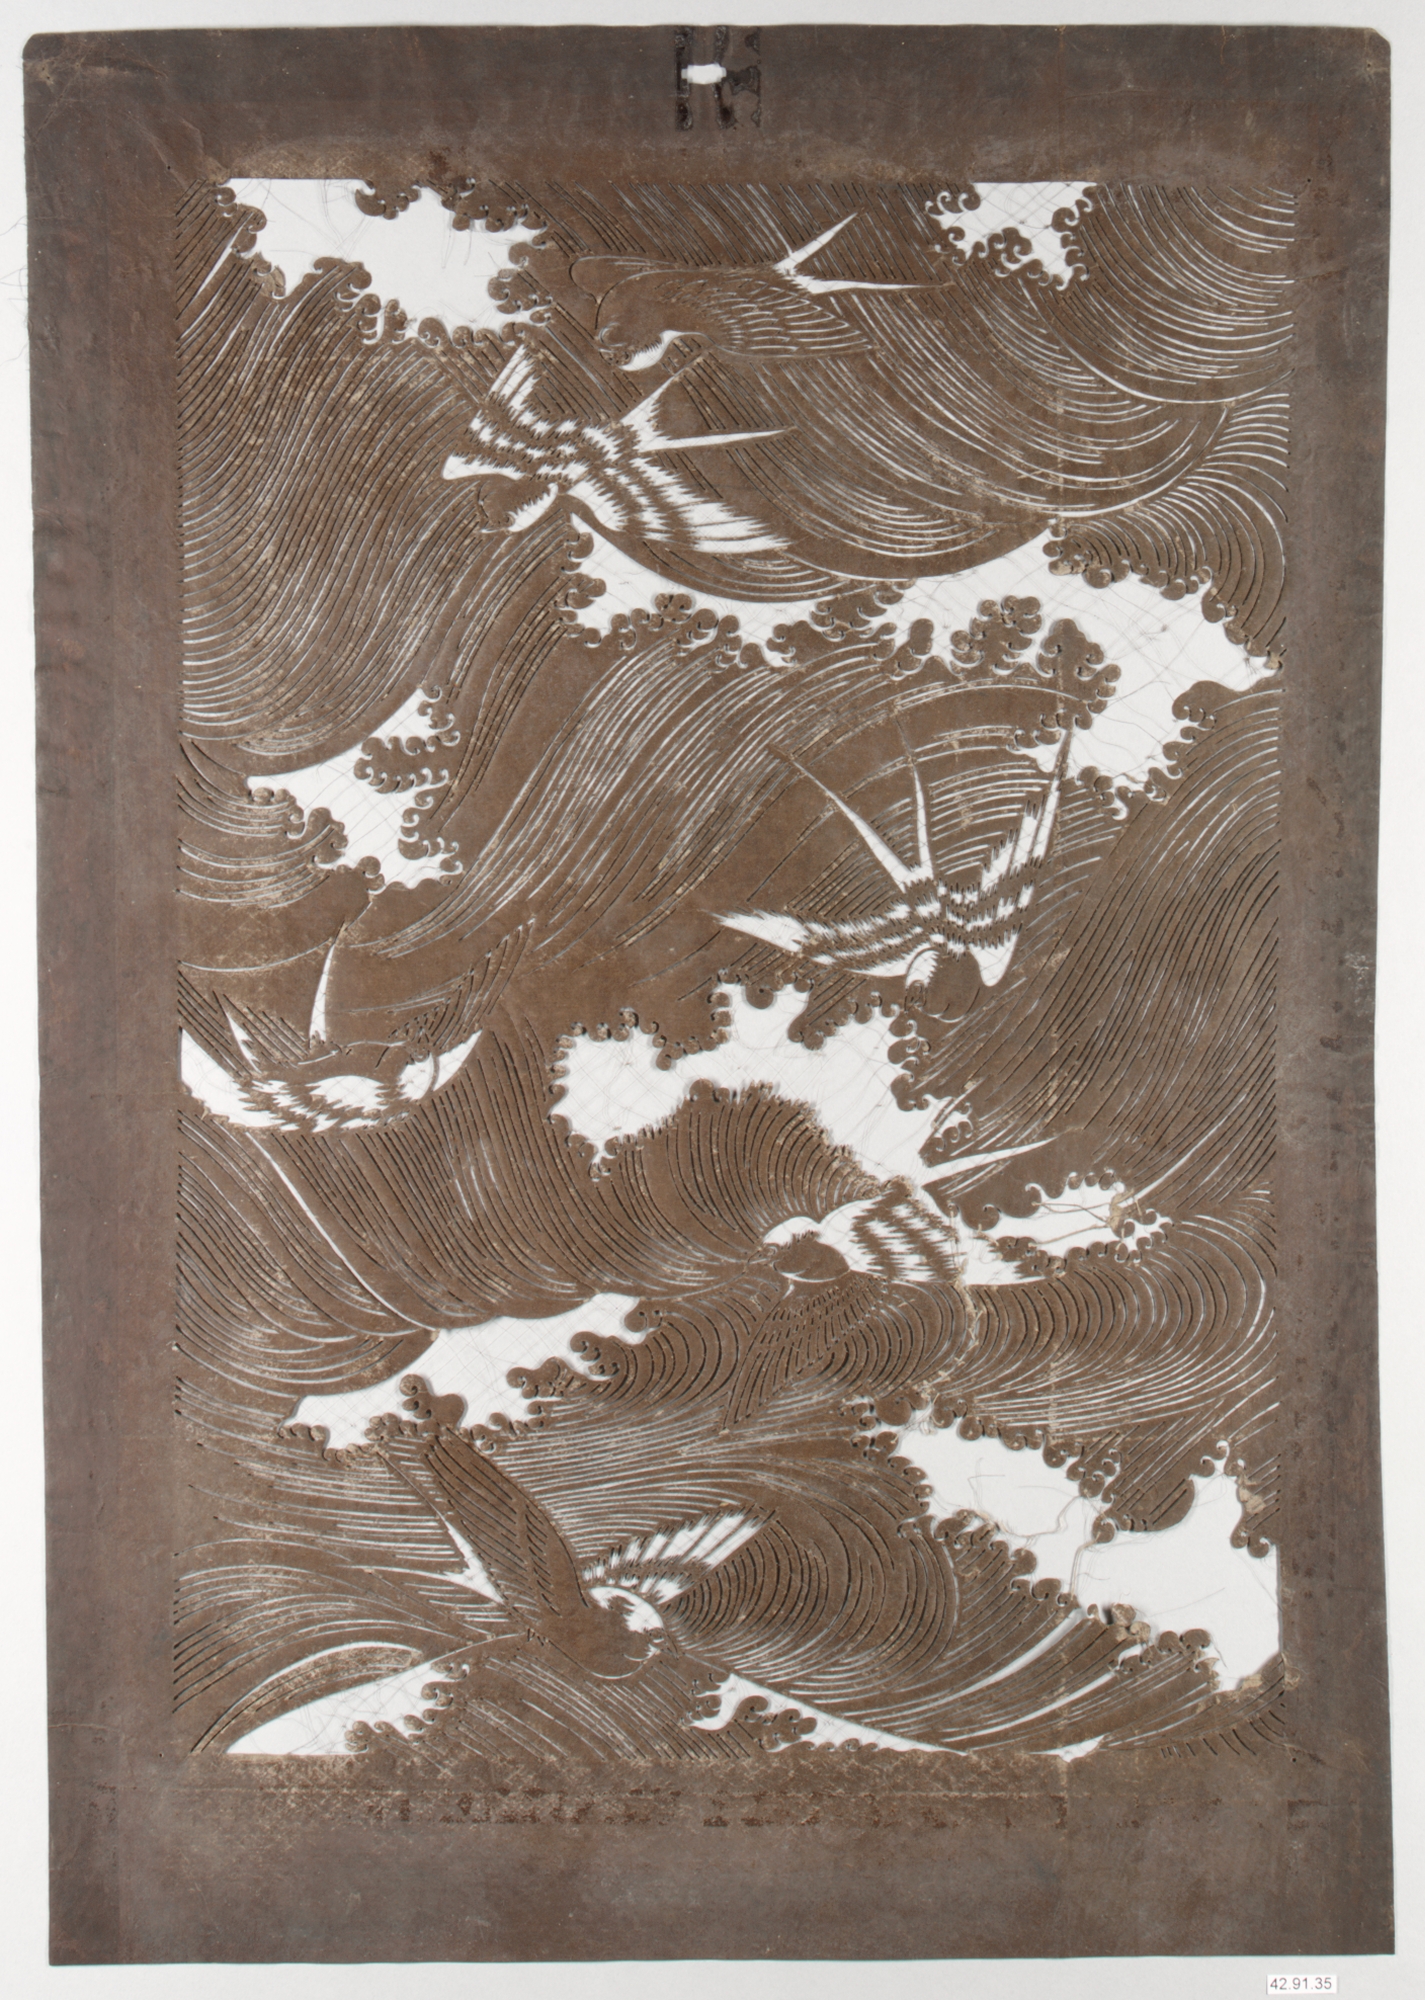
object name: stencil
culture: japanese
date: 1801-1900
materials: paper, silk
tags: birds,waves